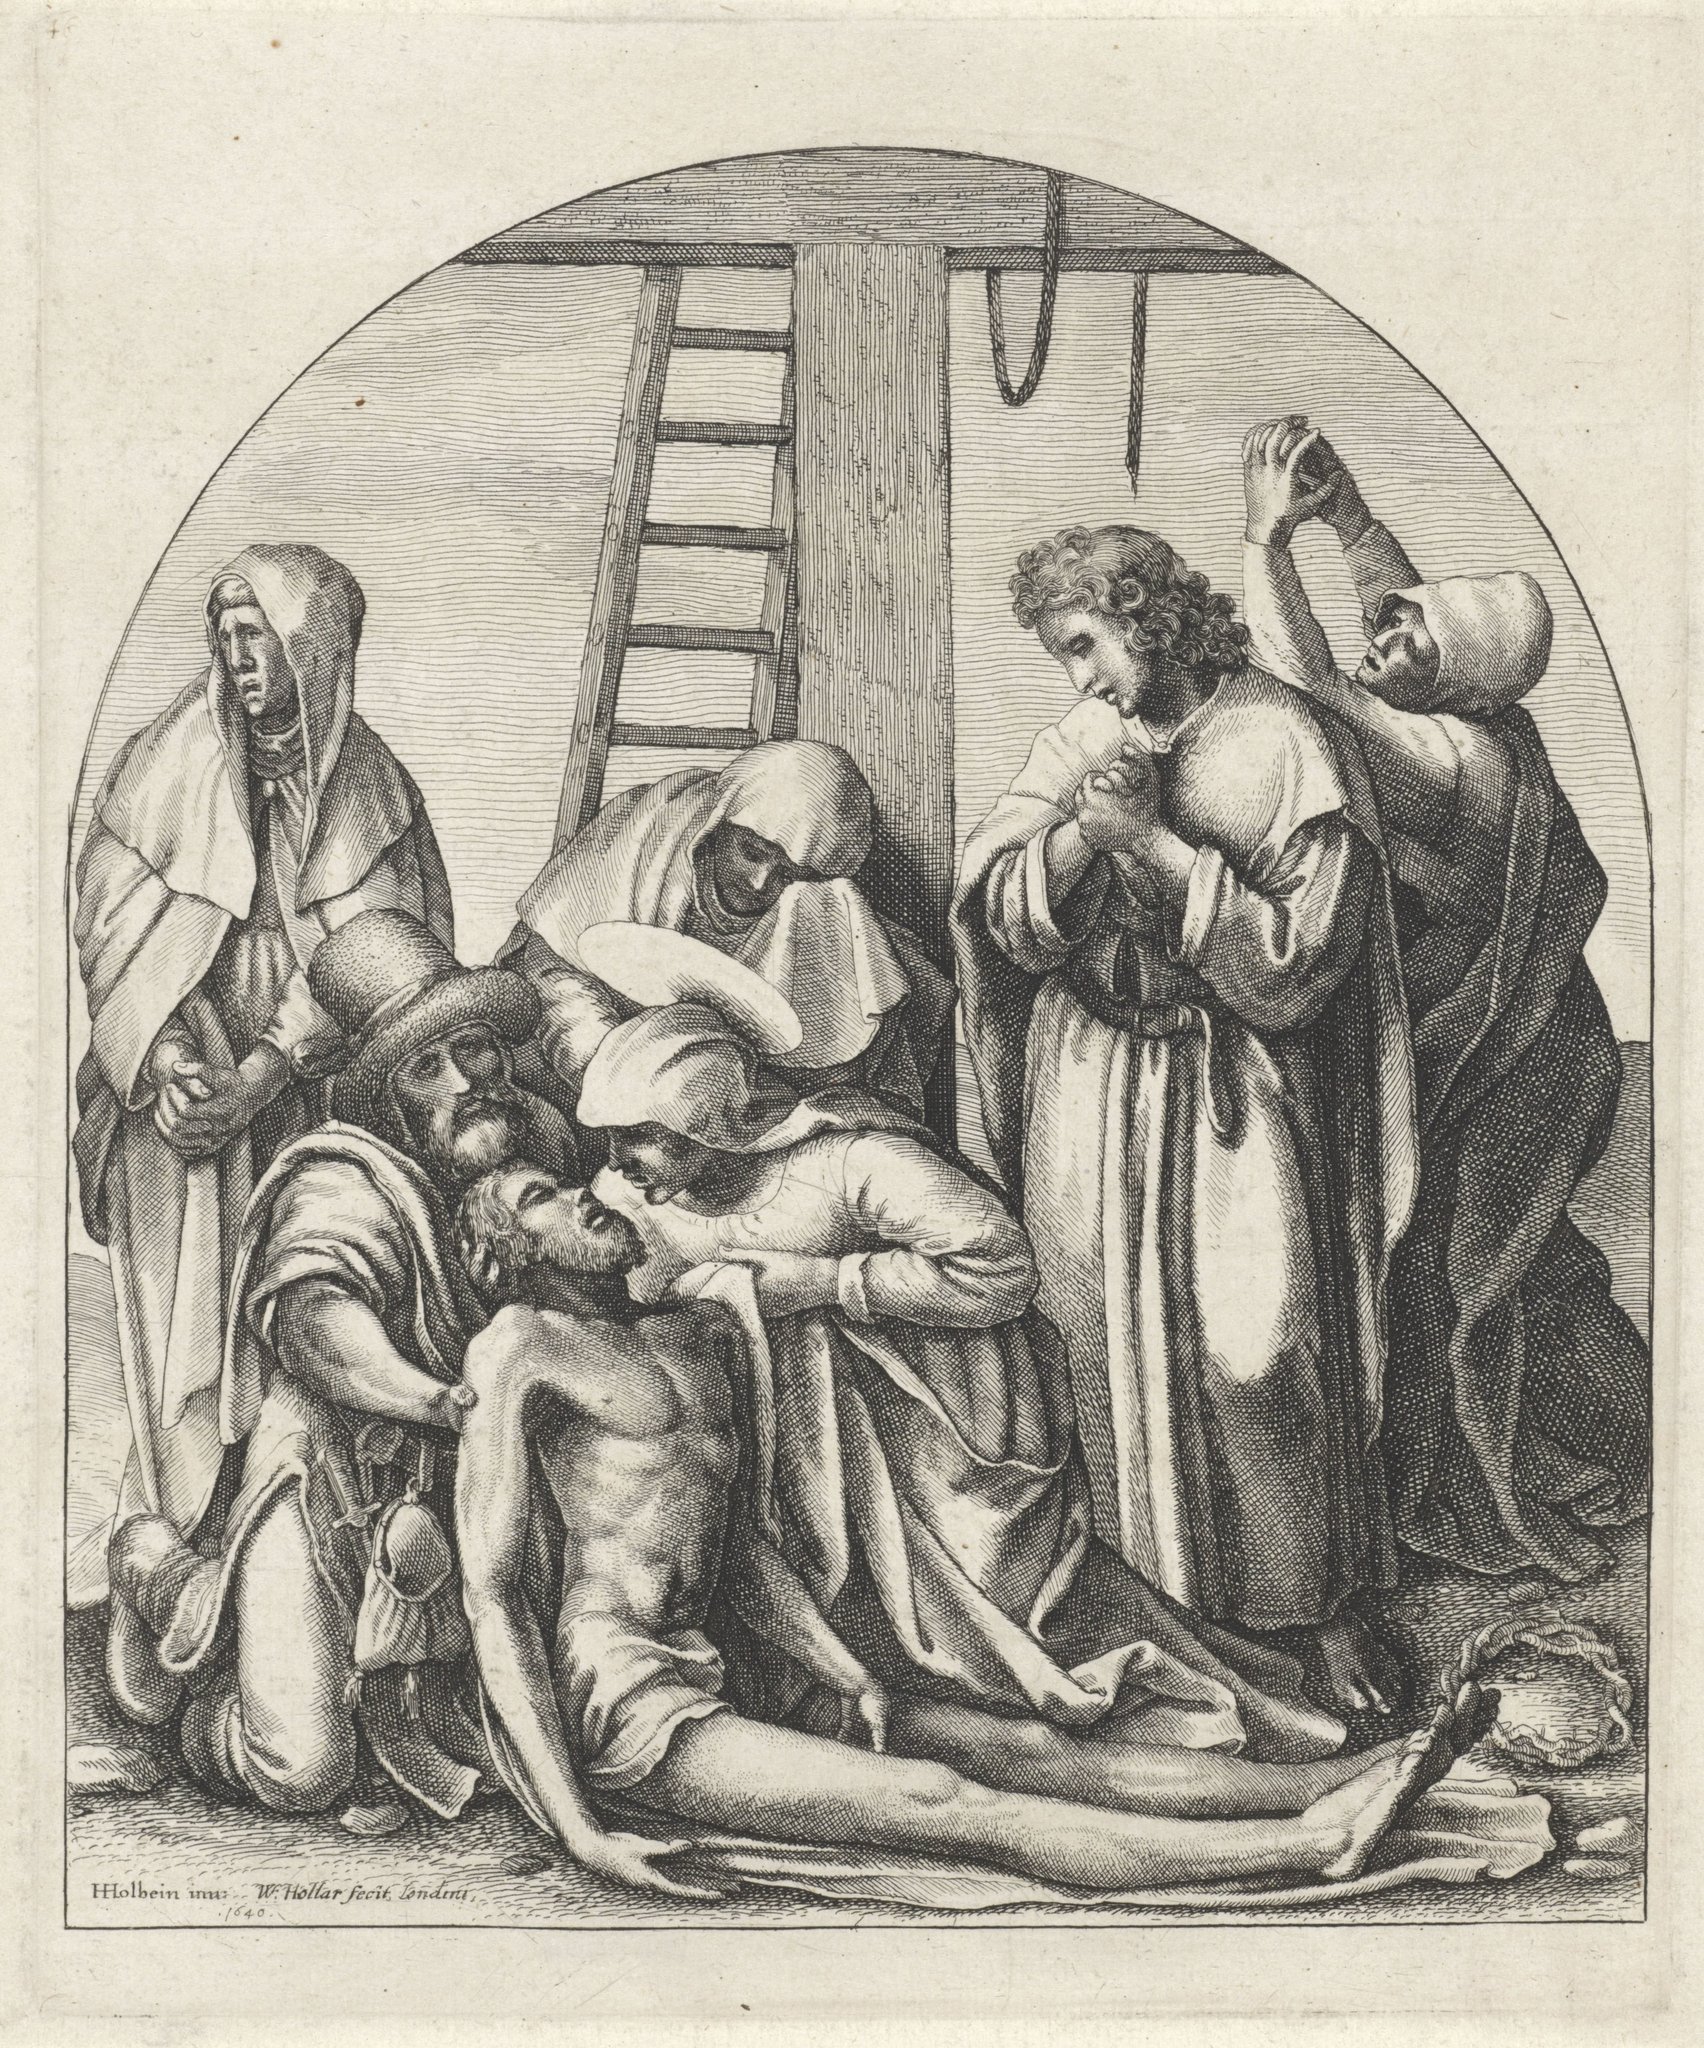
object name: print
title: Kruisafname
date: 1640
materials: paper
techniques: etching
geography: london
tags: christ is laid down ~ descent from the cross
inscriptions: collector's mark: Lugt 240